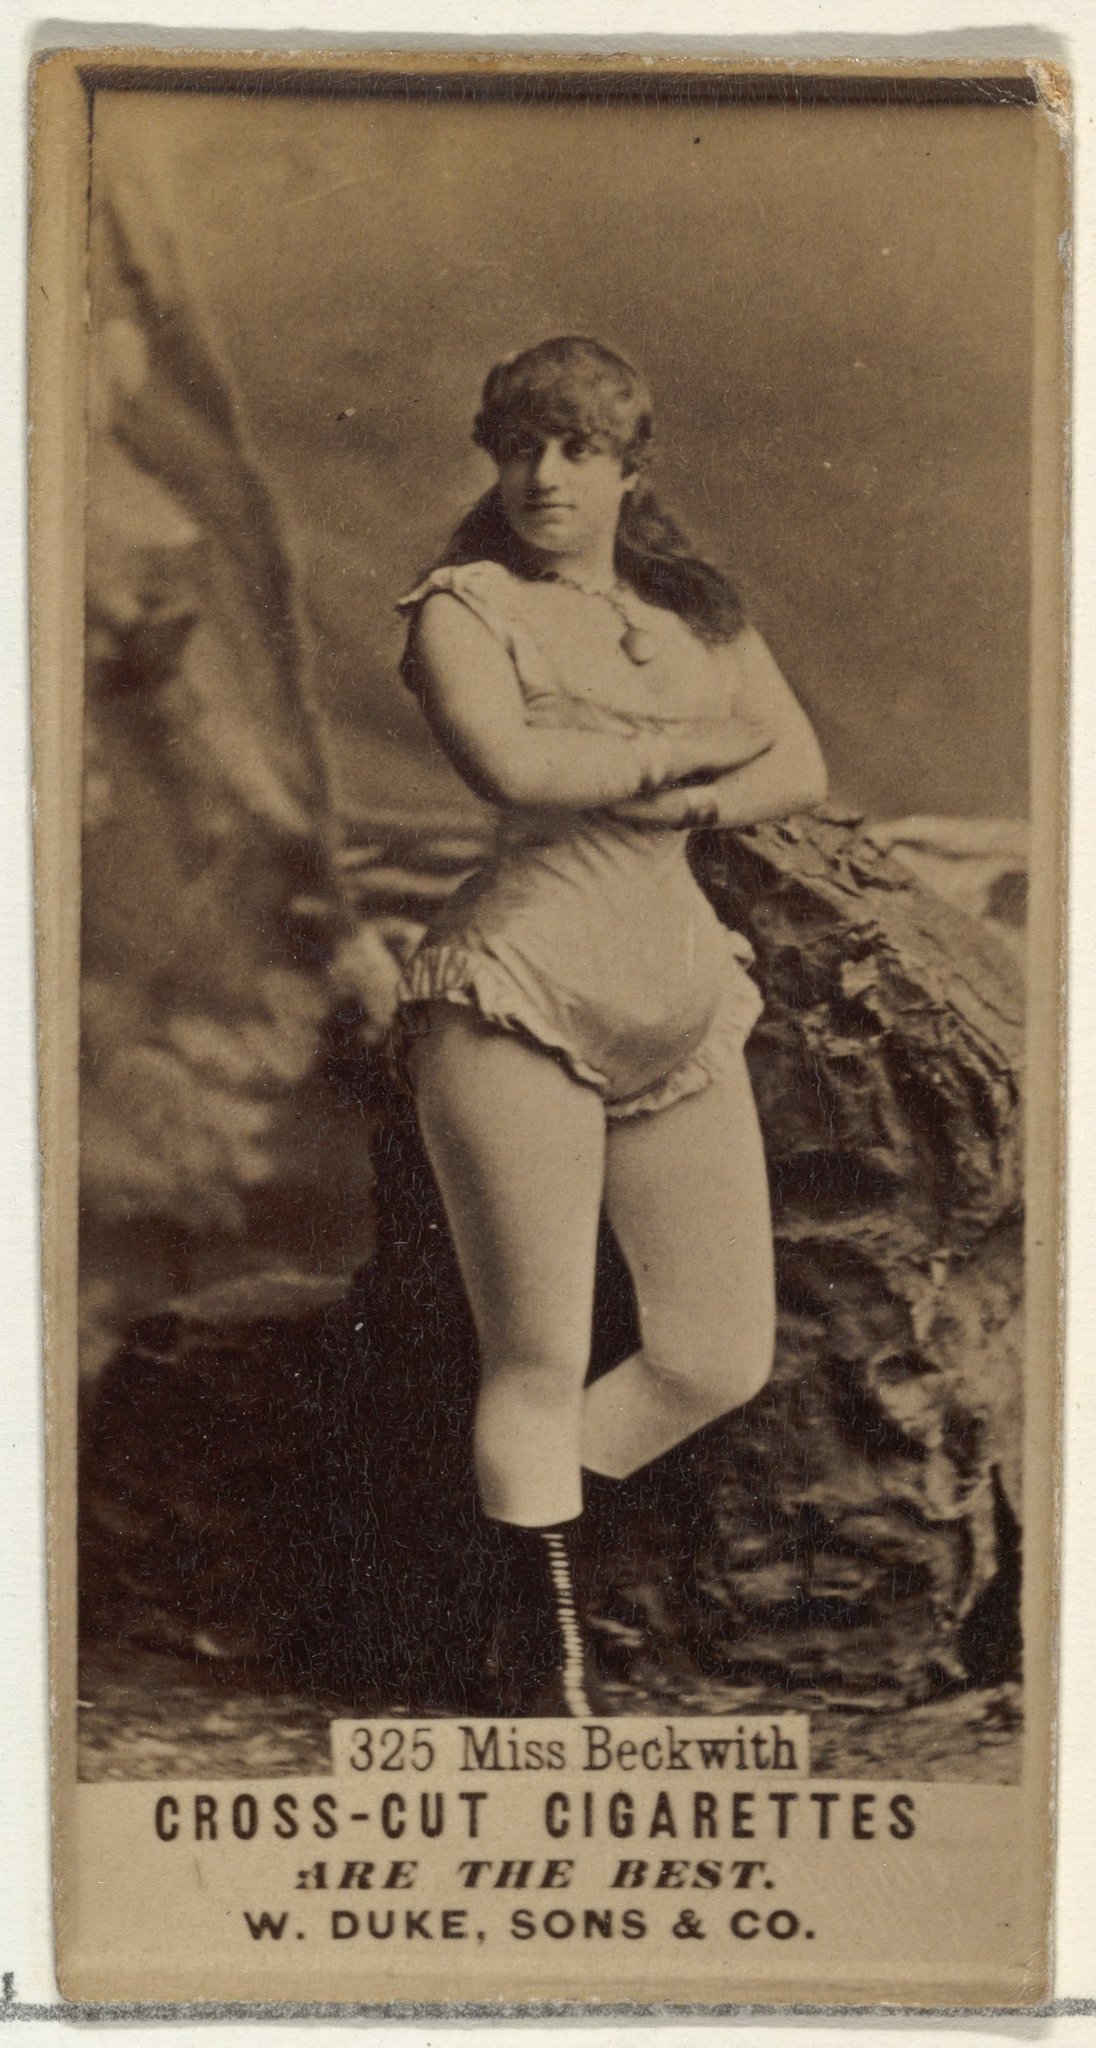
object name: photograph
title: Card Number 325, Miss Beckwith, from the Actors and Actresses series (N145-3) issued by Duke Sons & Co. to promote Cross Cut Cigarettes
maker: w. duke, sons & co.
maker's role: publisher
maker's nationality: american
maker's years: 1870-1920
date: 1880-1889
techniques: albumen silver print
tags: portraits,women,actresses